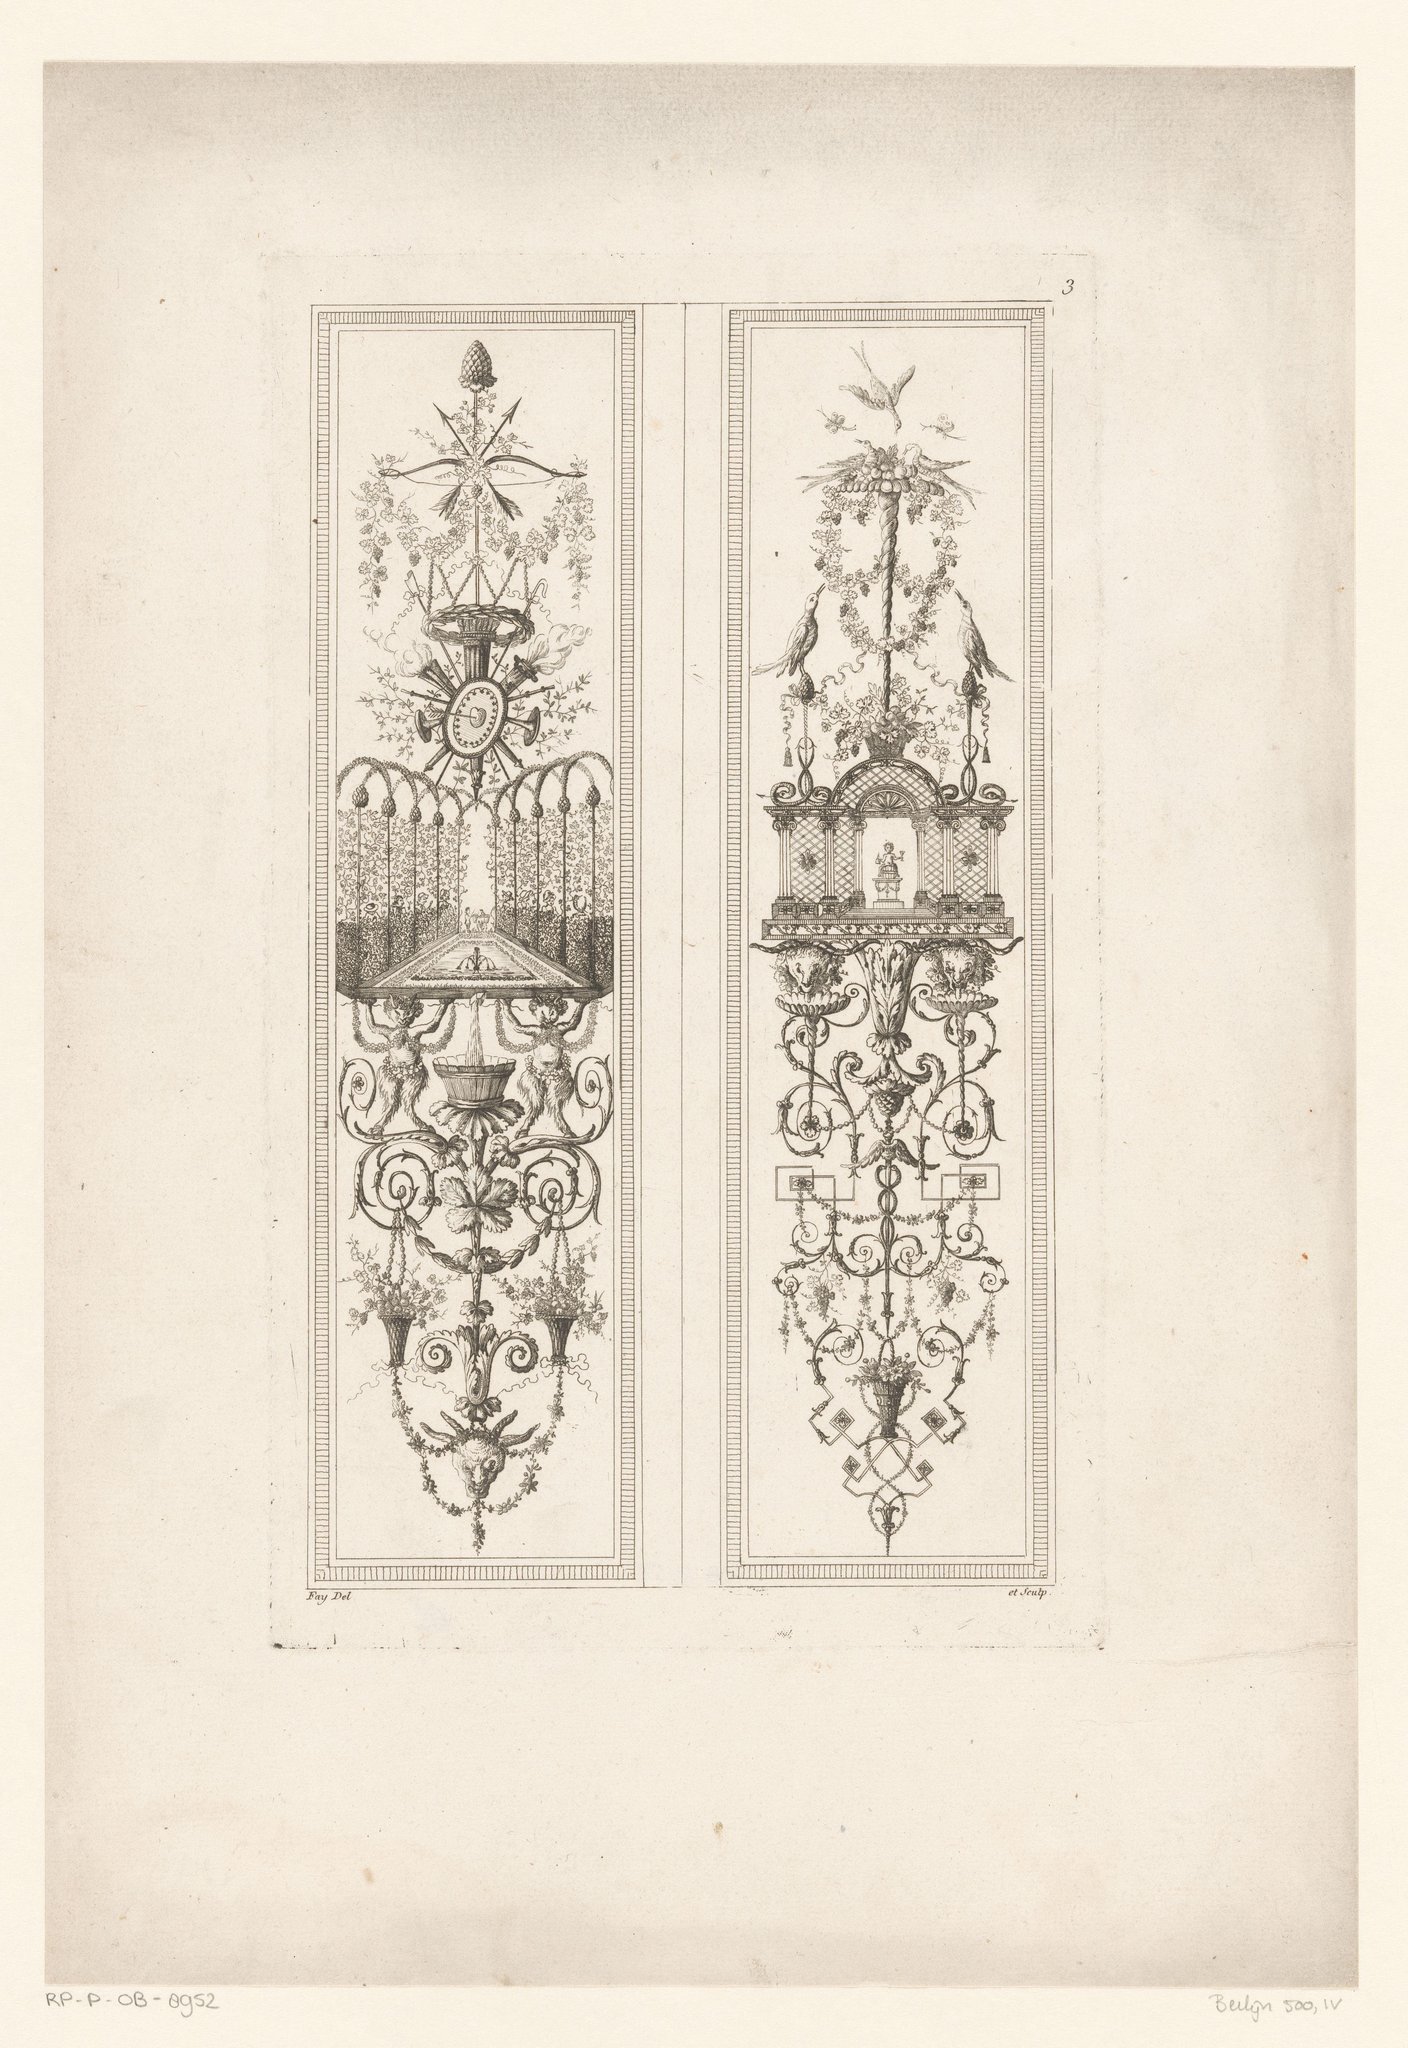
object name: print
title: Arabesken met tuinlandschap en prieel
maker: jean baptiste fay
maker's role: print maker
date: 1784-1796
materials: paper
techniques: engraving, etching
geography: paris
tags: ornament ~ arabesque, garden, garden buildings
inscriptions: collector's mark: Lugt 2228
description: Twee verticale panelen met arabesken. Links met thyrsus, pijlen en boog, een trofee met fakkels, schild en pijlenkoker, een tuilandschap met vijver, saters en manden met bloemen. Rechts met kransen, vogels, een prieel, maskers, druiventrossen en een mand met bloemen.